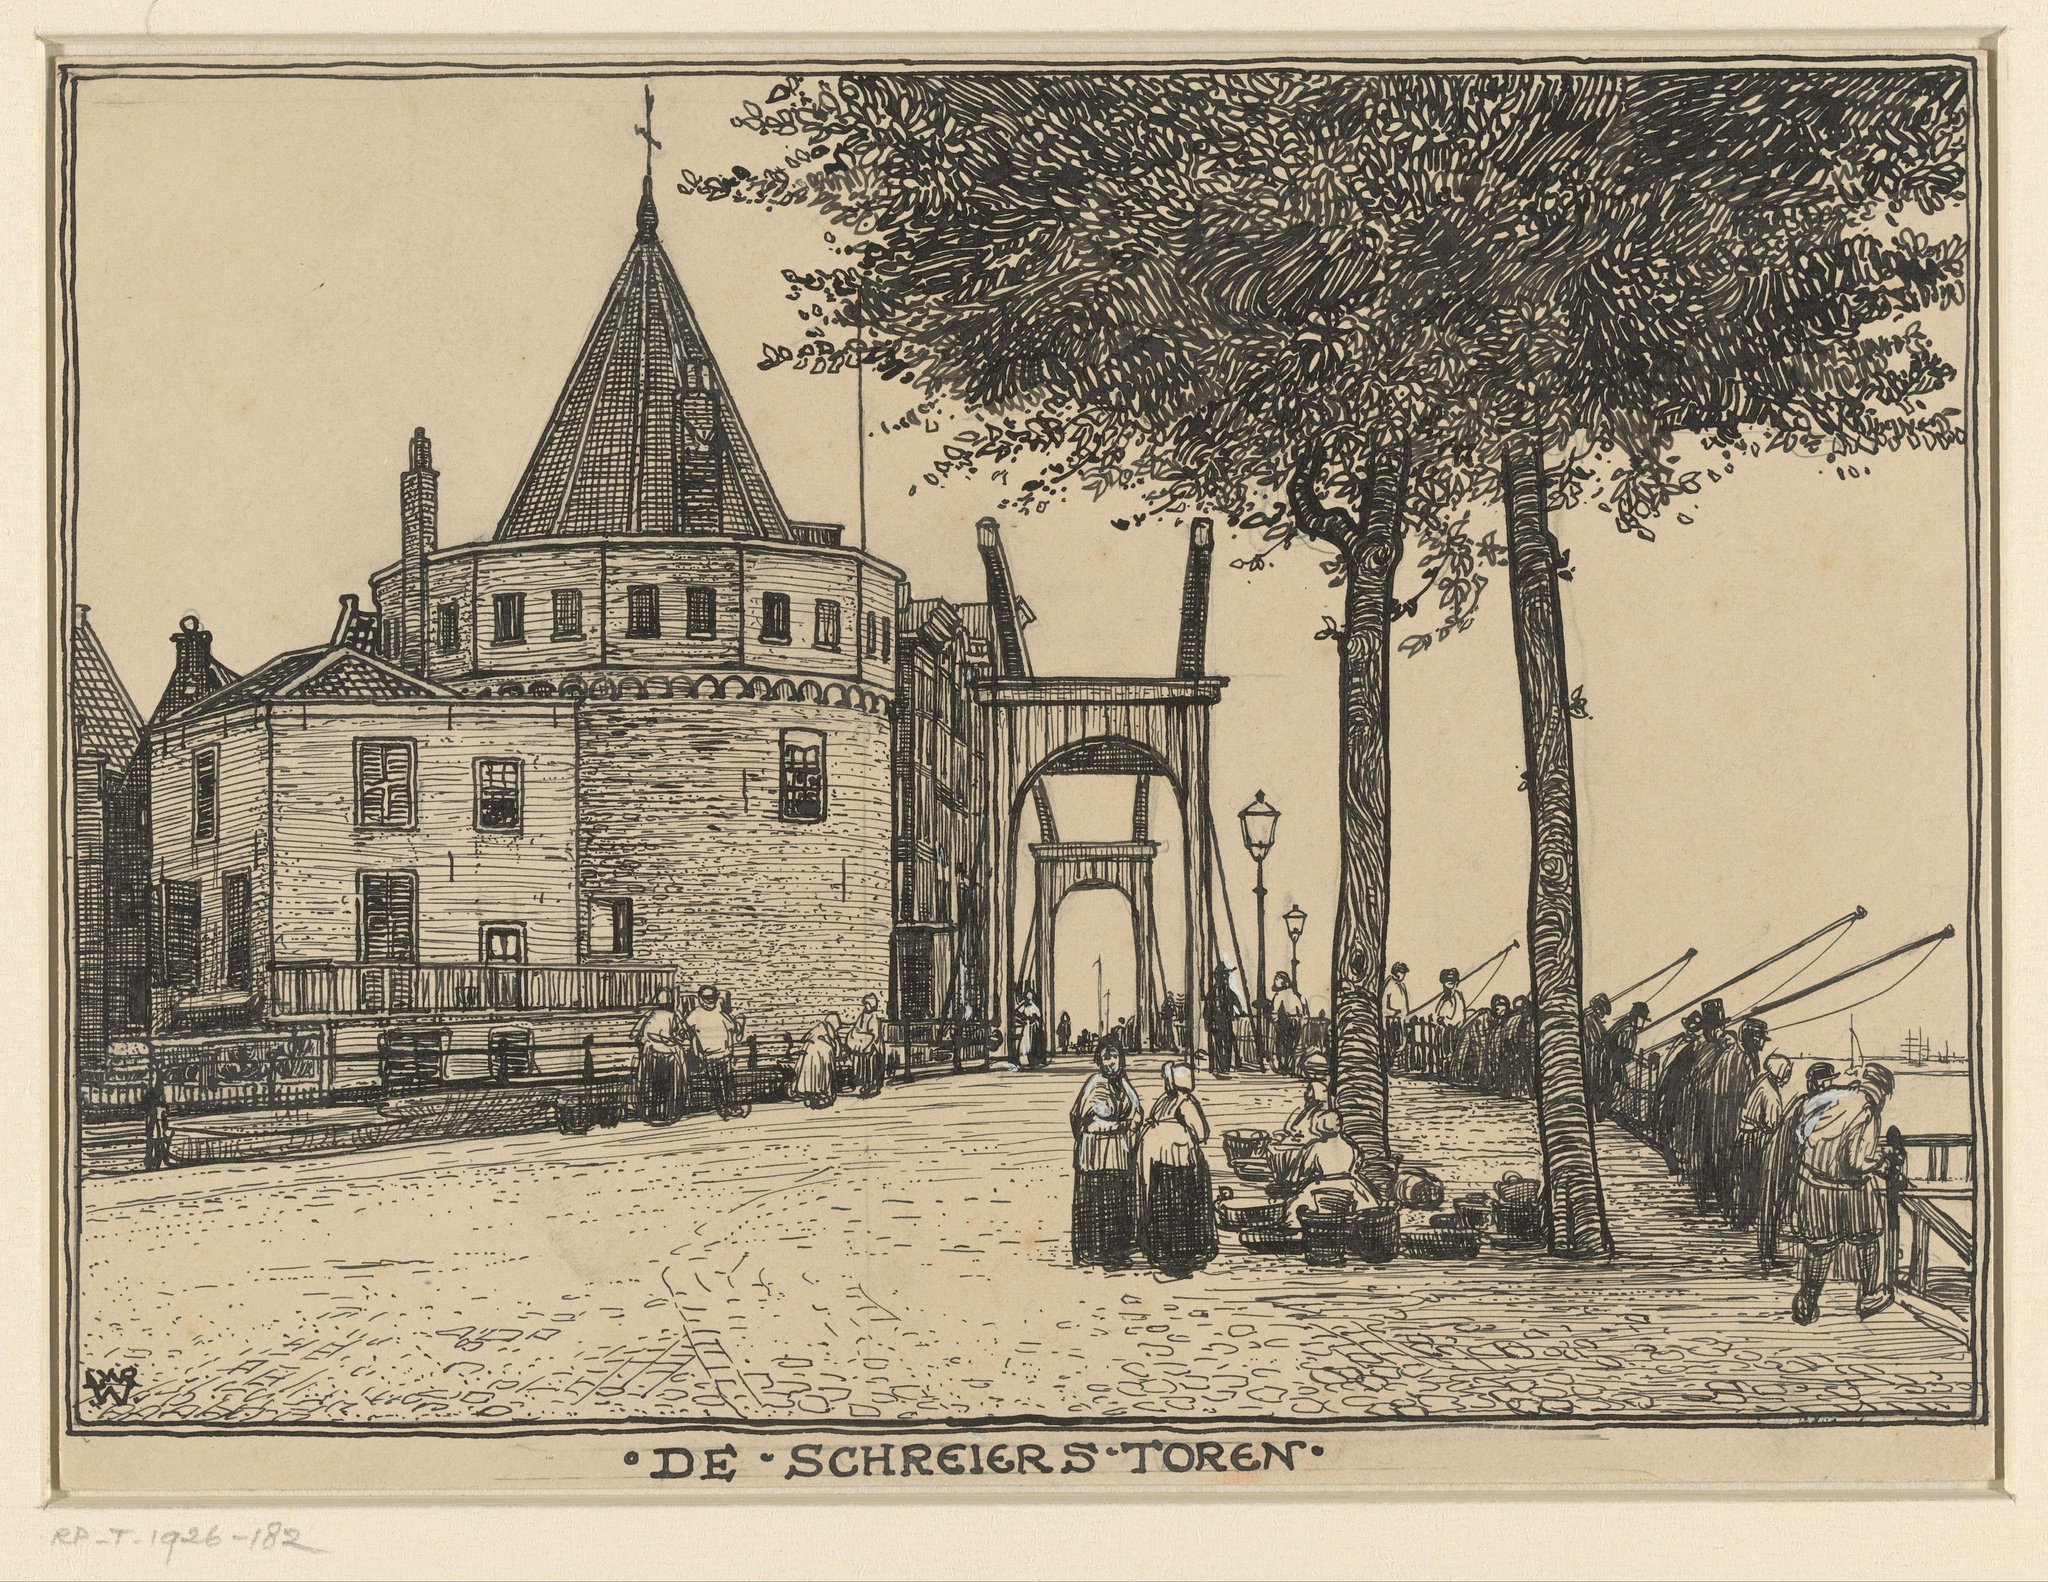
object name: drawing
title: Schreiers toren te Amsterdam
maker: willem wenckebach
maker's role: designer, draughtsman, painter, print maker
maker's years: 1860-1937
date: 1870-1926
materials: cardboard, paint, ink, pencil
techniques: pen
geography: amsterdam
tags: city-view, and landscape with man-made constructions, amsterdam